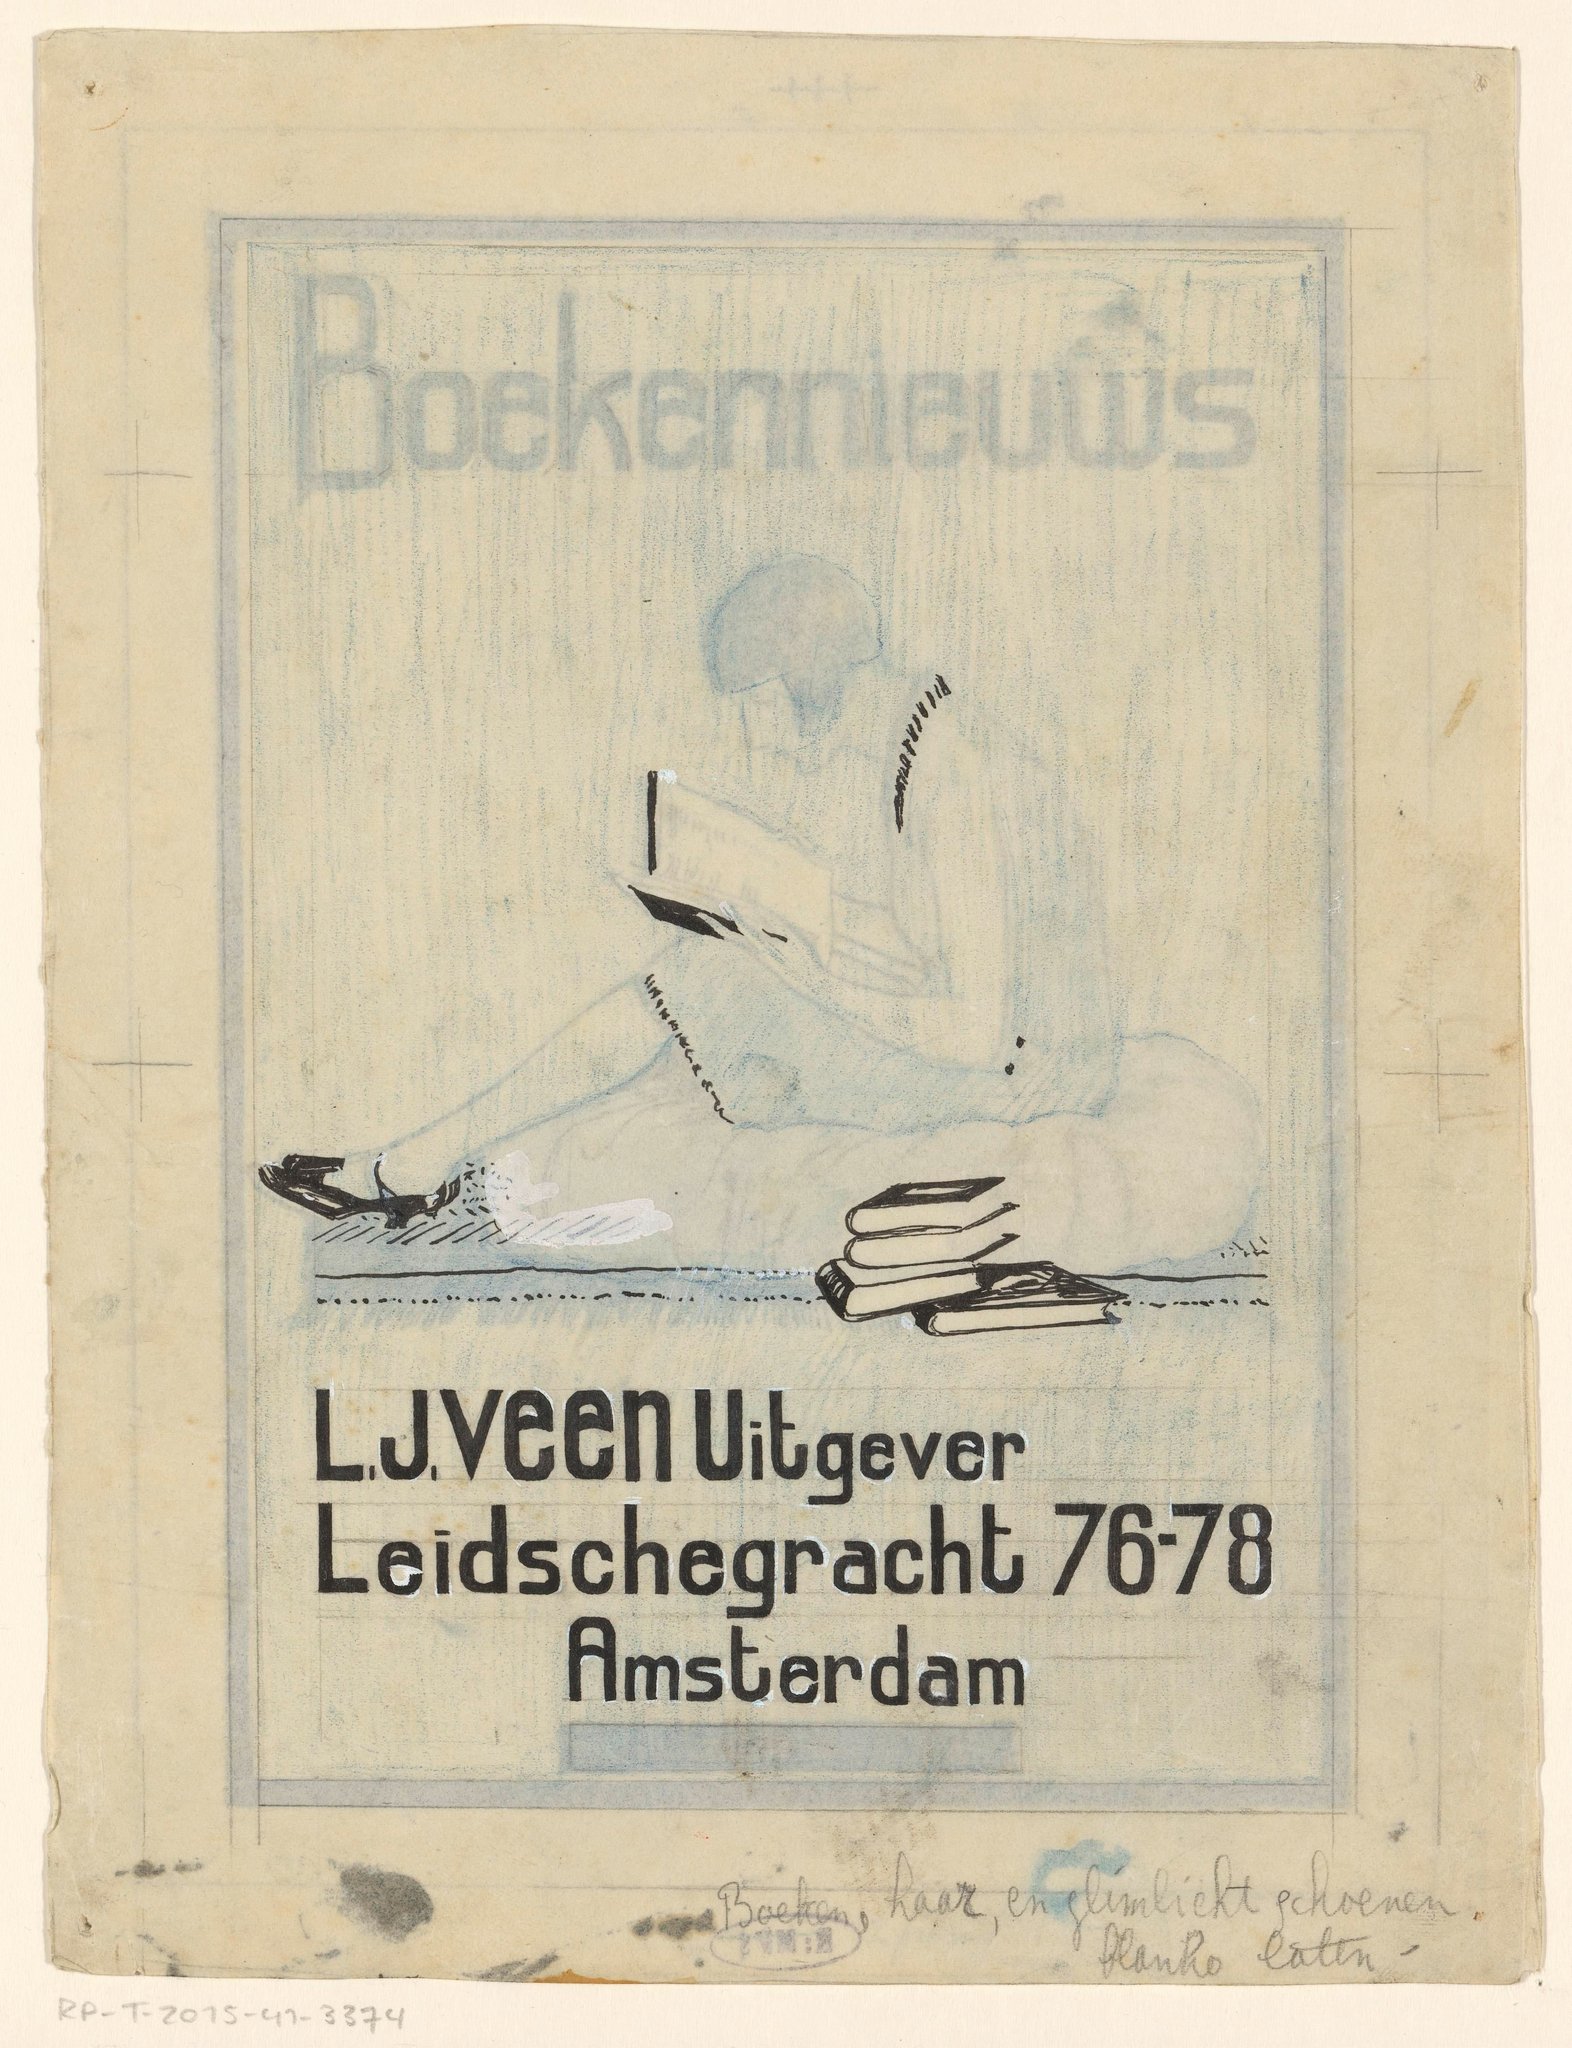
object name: drawing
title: Bandontwerp voor: Boekennieuws: uitgever L.J. Veen, c. 1930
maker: Anonymous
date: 1930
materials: paint, ink, paper, pencil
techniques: brush, pen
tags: reading, sitting figure - aa - female human figure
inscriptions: :, collector's mark: Lugt 2228a, monogram: ‘AL’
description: Ontwerp voor een fondscatalogus van Uitgeversmaatschappij L.J. Veen te Amsterdam. Een vrouw met een kort kapsel zit op een kussen op de grond te lezen. Naast haar ligt een stapel boeken.